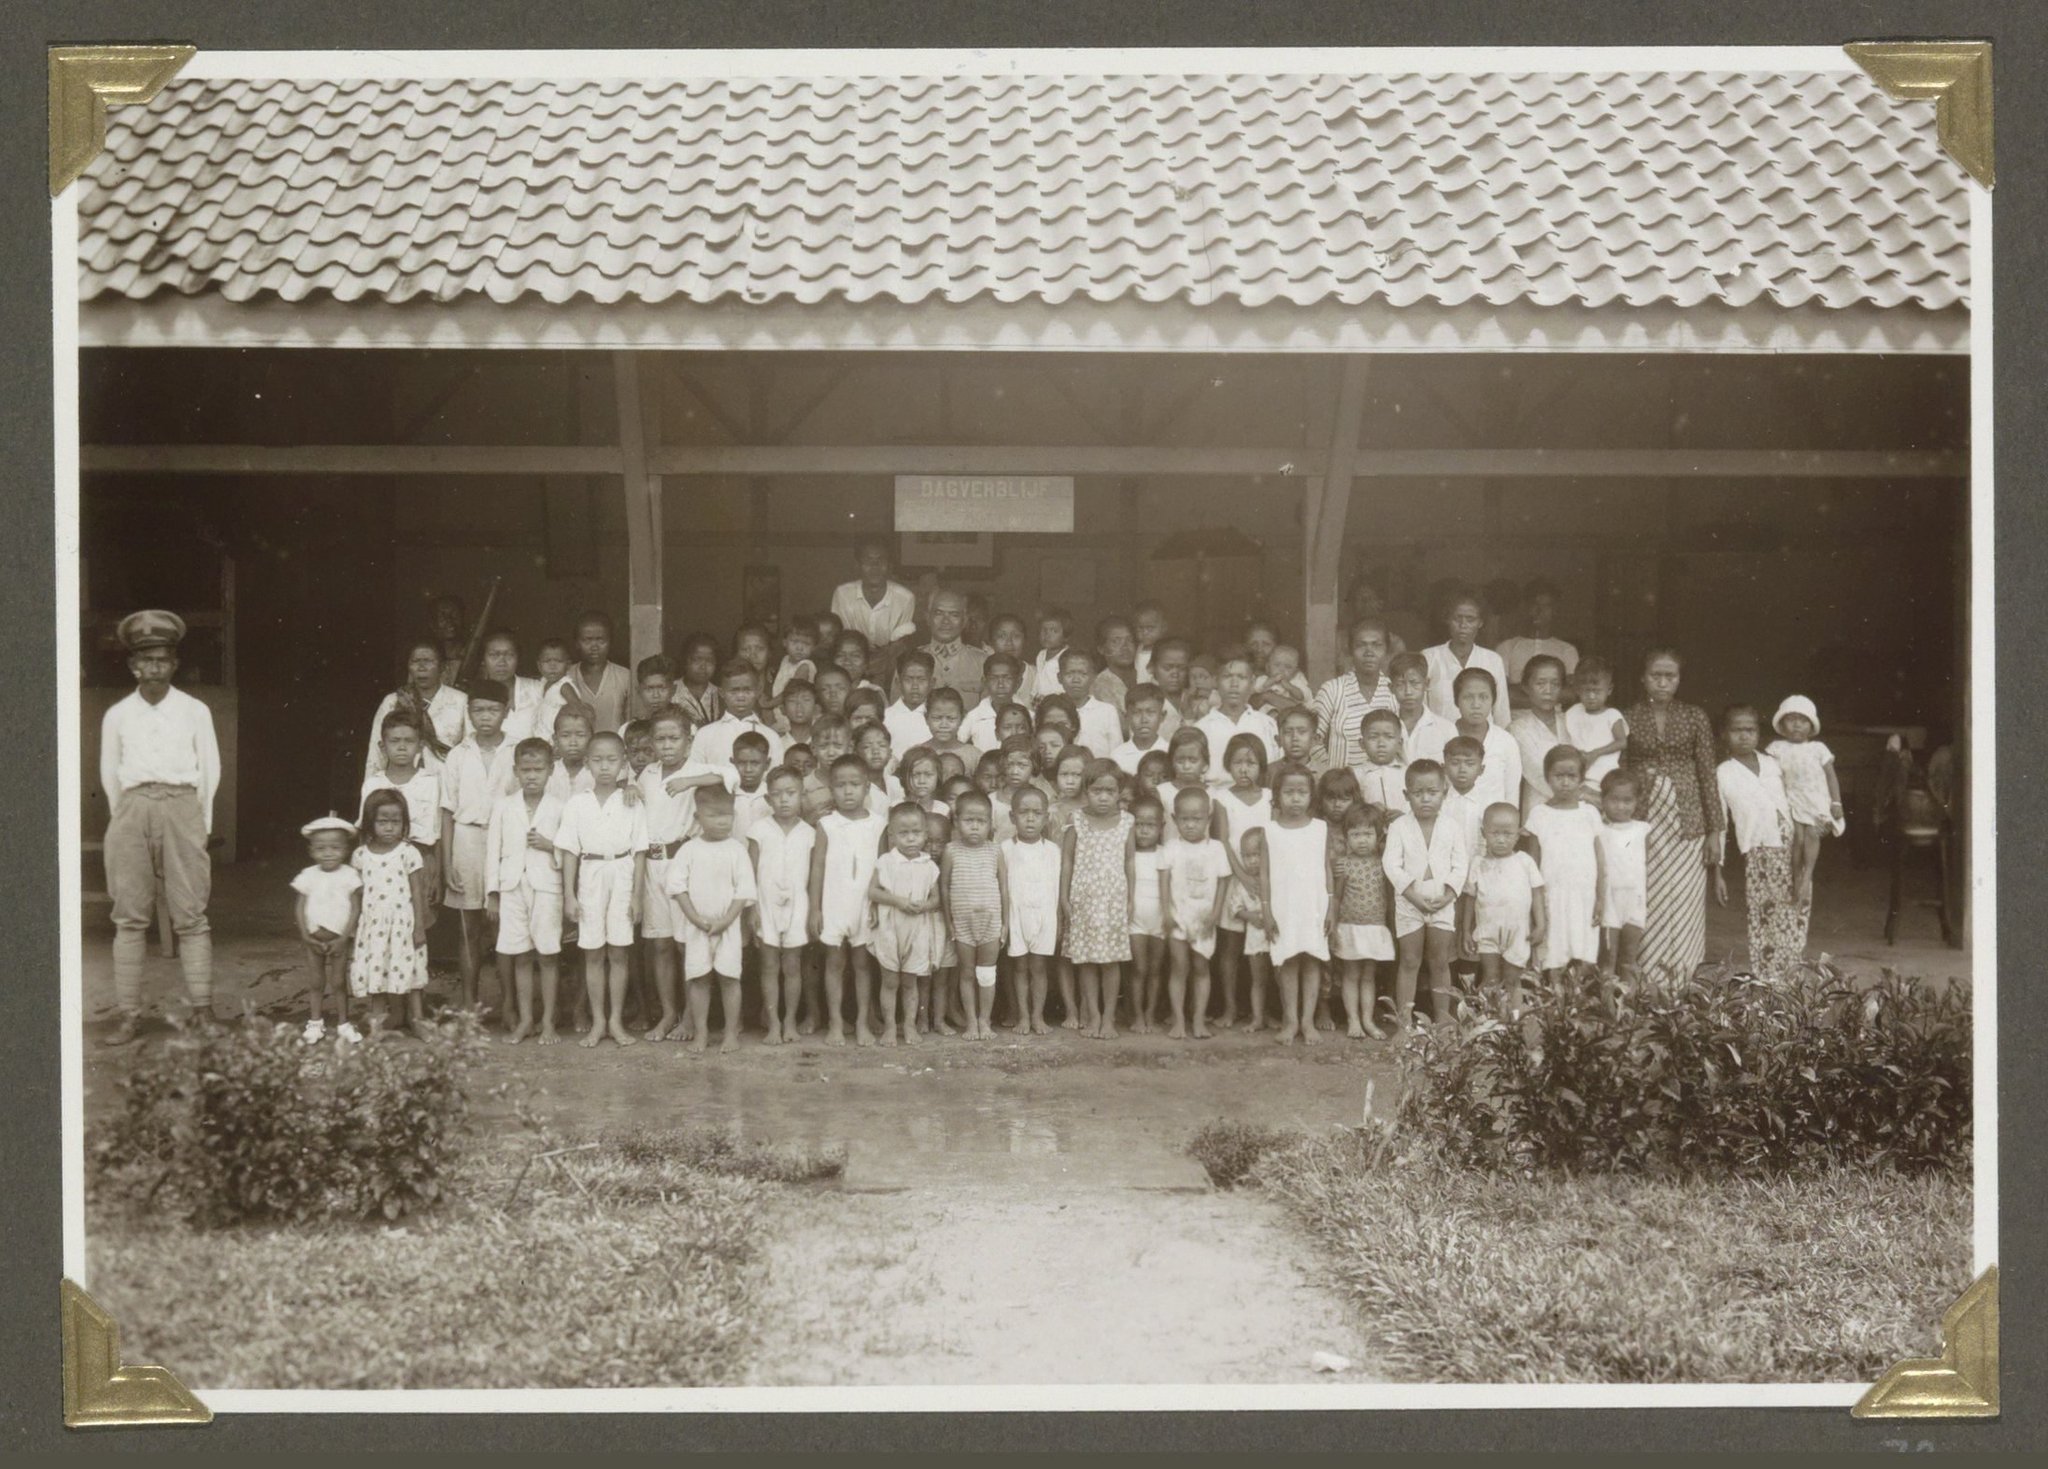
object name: photograph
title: Groepsportret van Indische kinderen en leerkrachten voor een dagverblijf in Lampong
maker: Anonymous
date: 1932-1933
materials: photographic support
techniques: gelatin silver print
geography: lampung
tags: child, nursery school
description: Onderdeel van Herinneringsalbum voor F.J. Junius, vertrekkend resident van Lampong (Zuid-Sumatra).